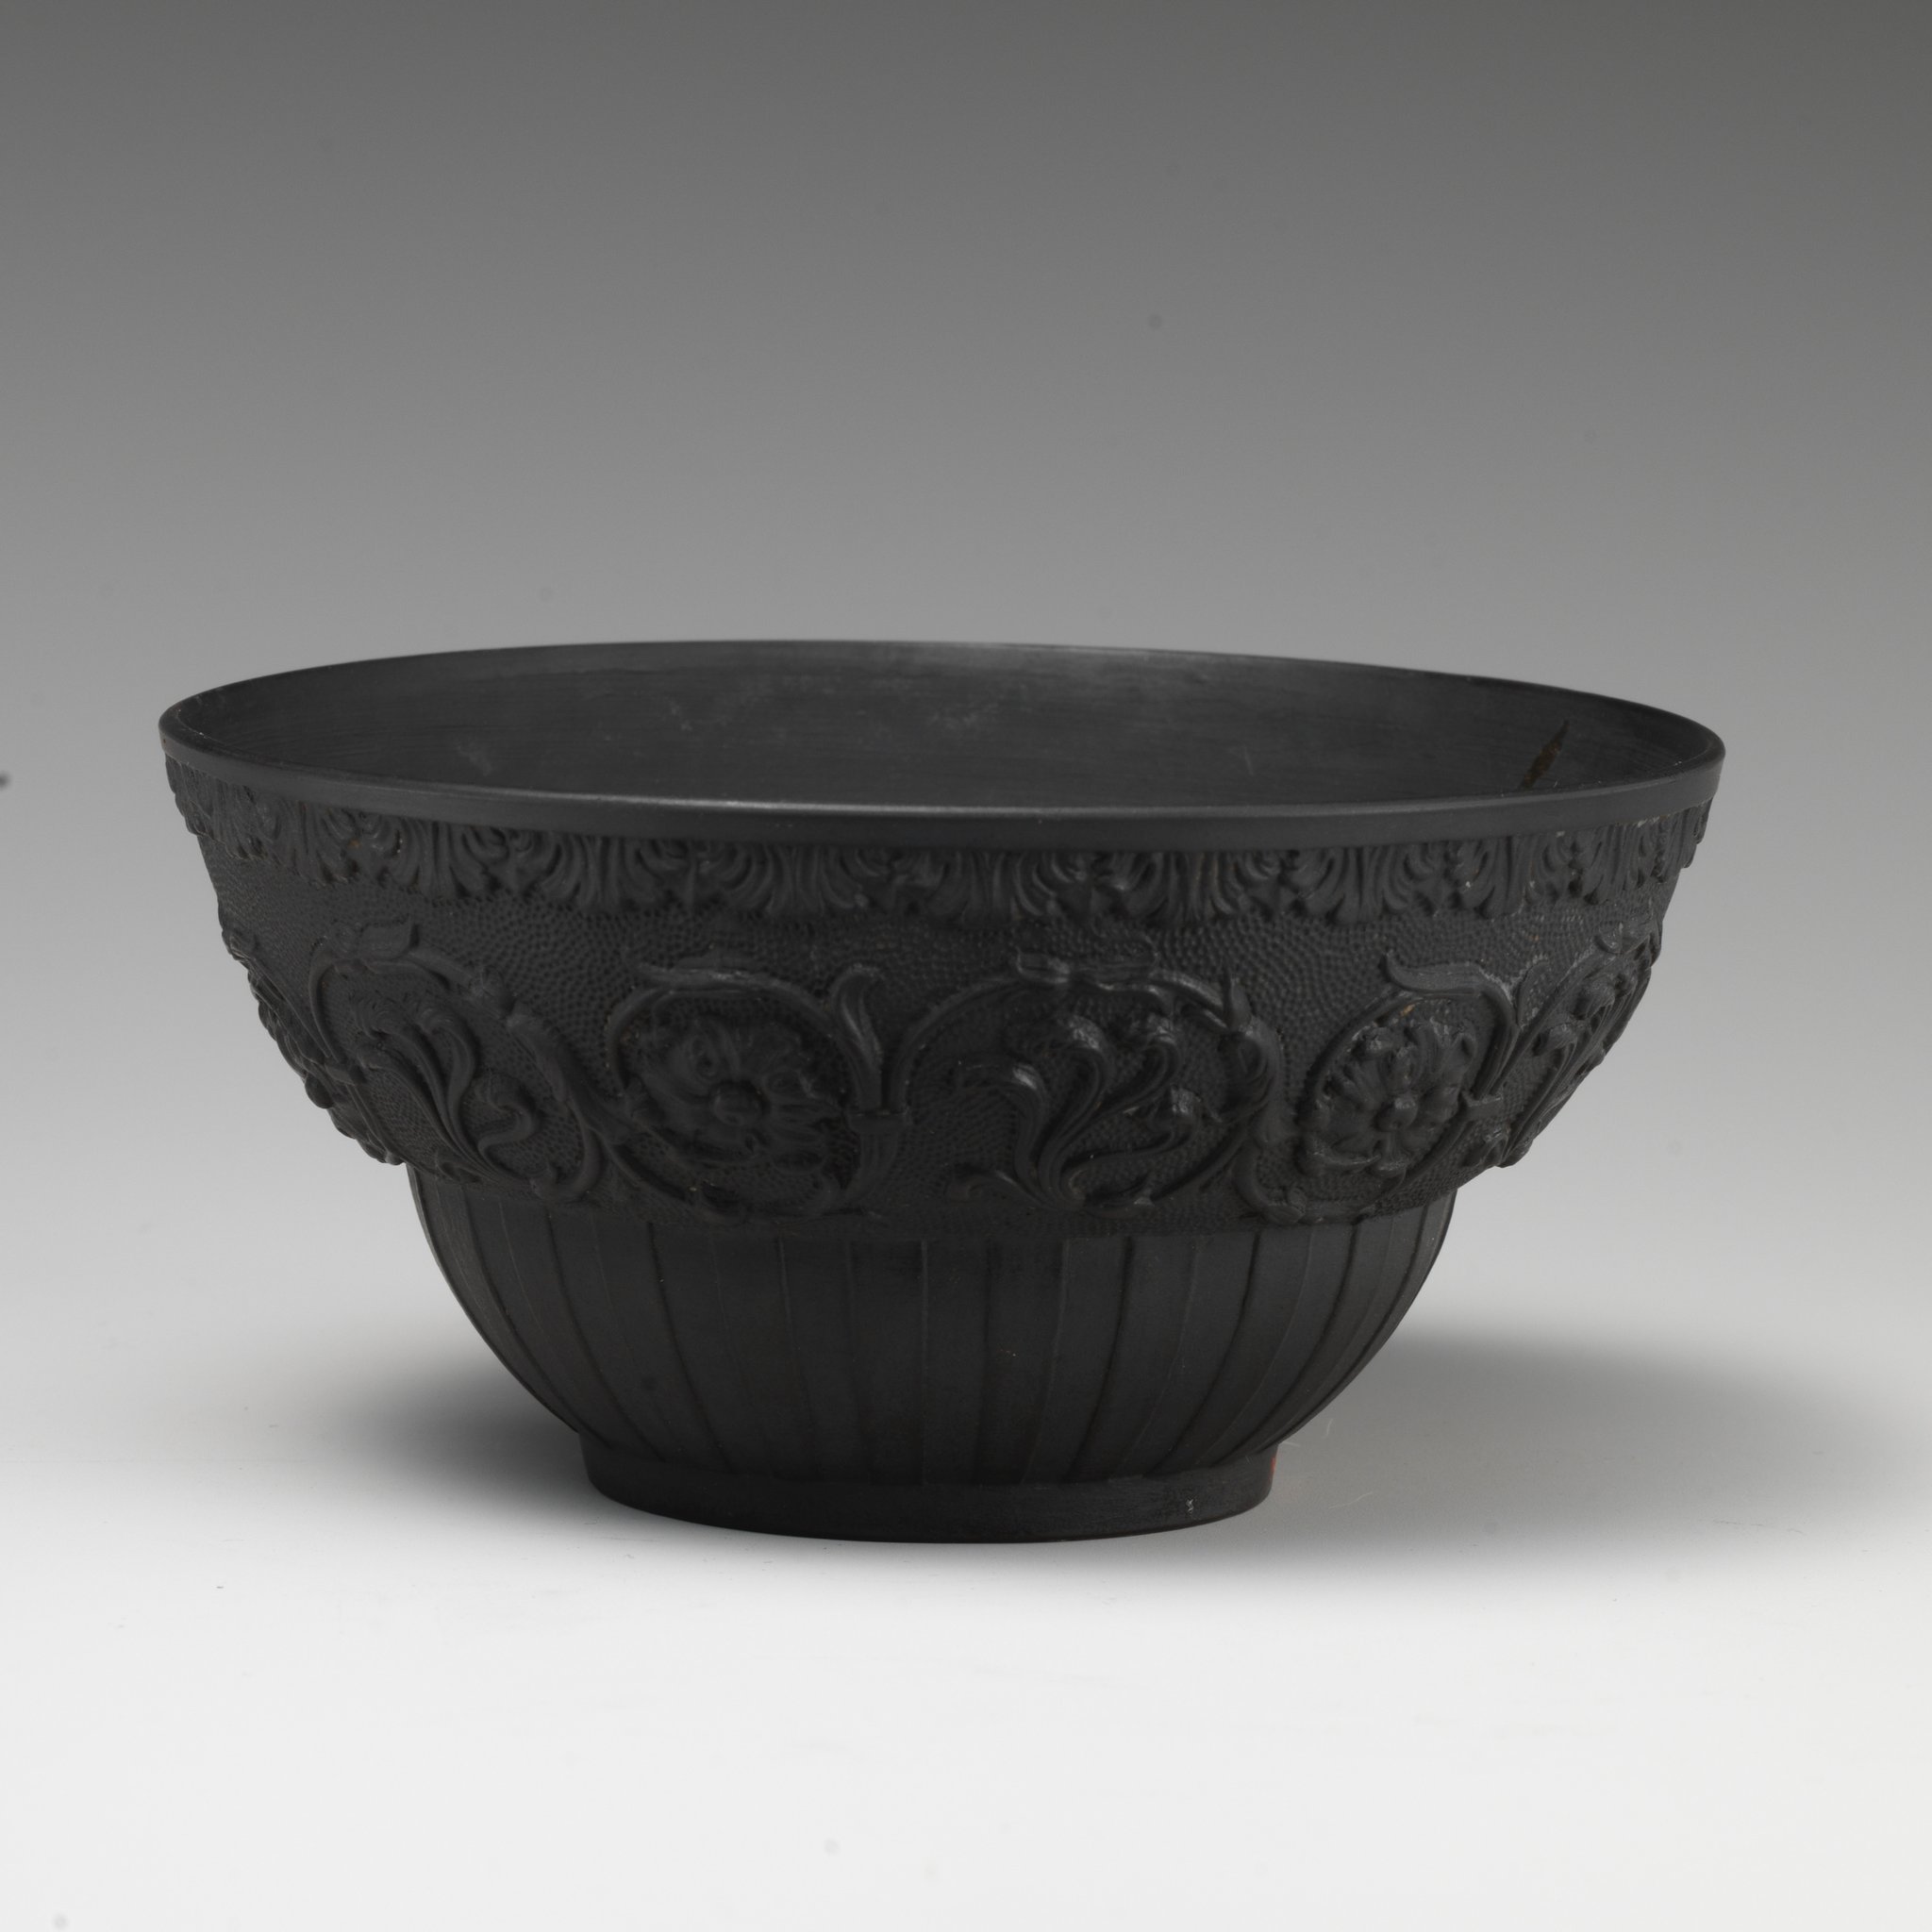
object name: bowl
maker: wedgwood and bentley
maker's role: maker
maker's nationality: british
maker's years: 1769-1780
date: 1701-1800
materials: stone